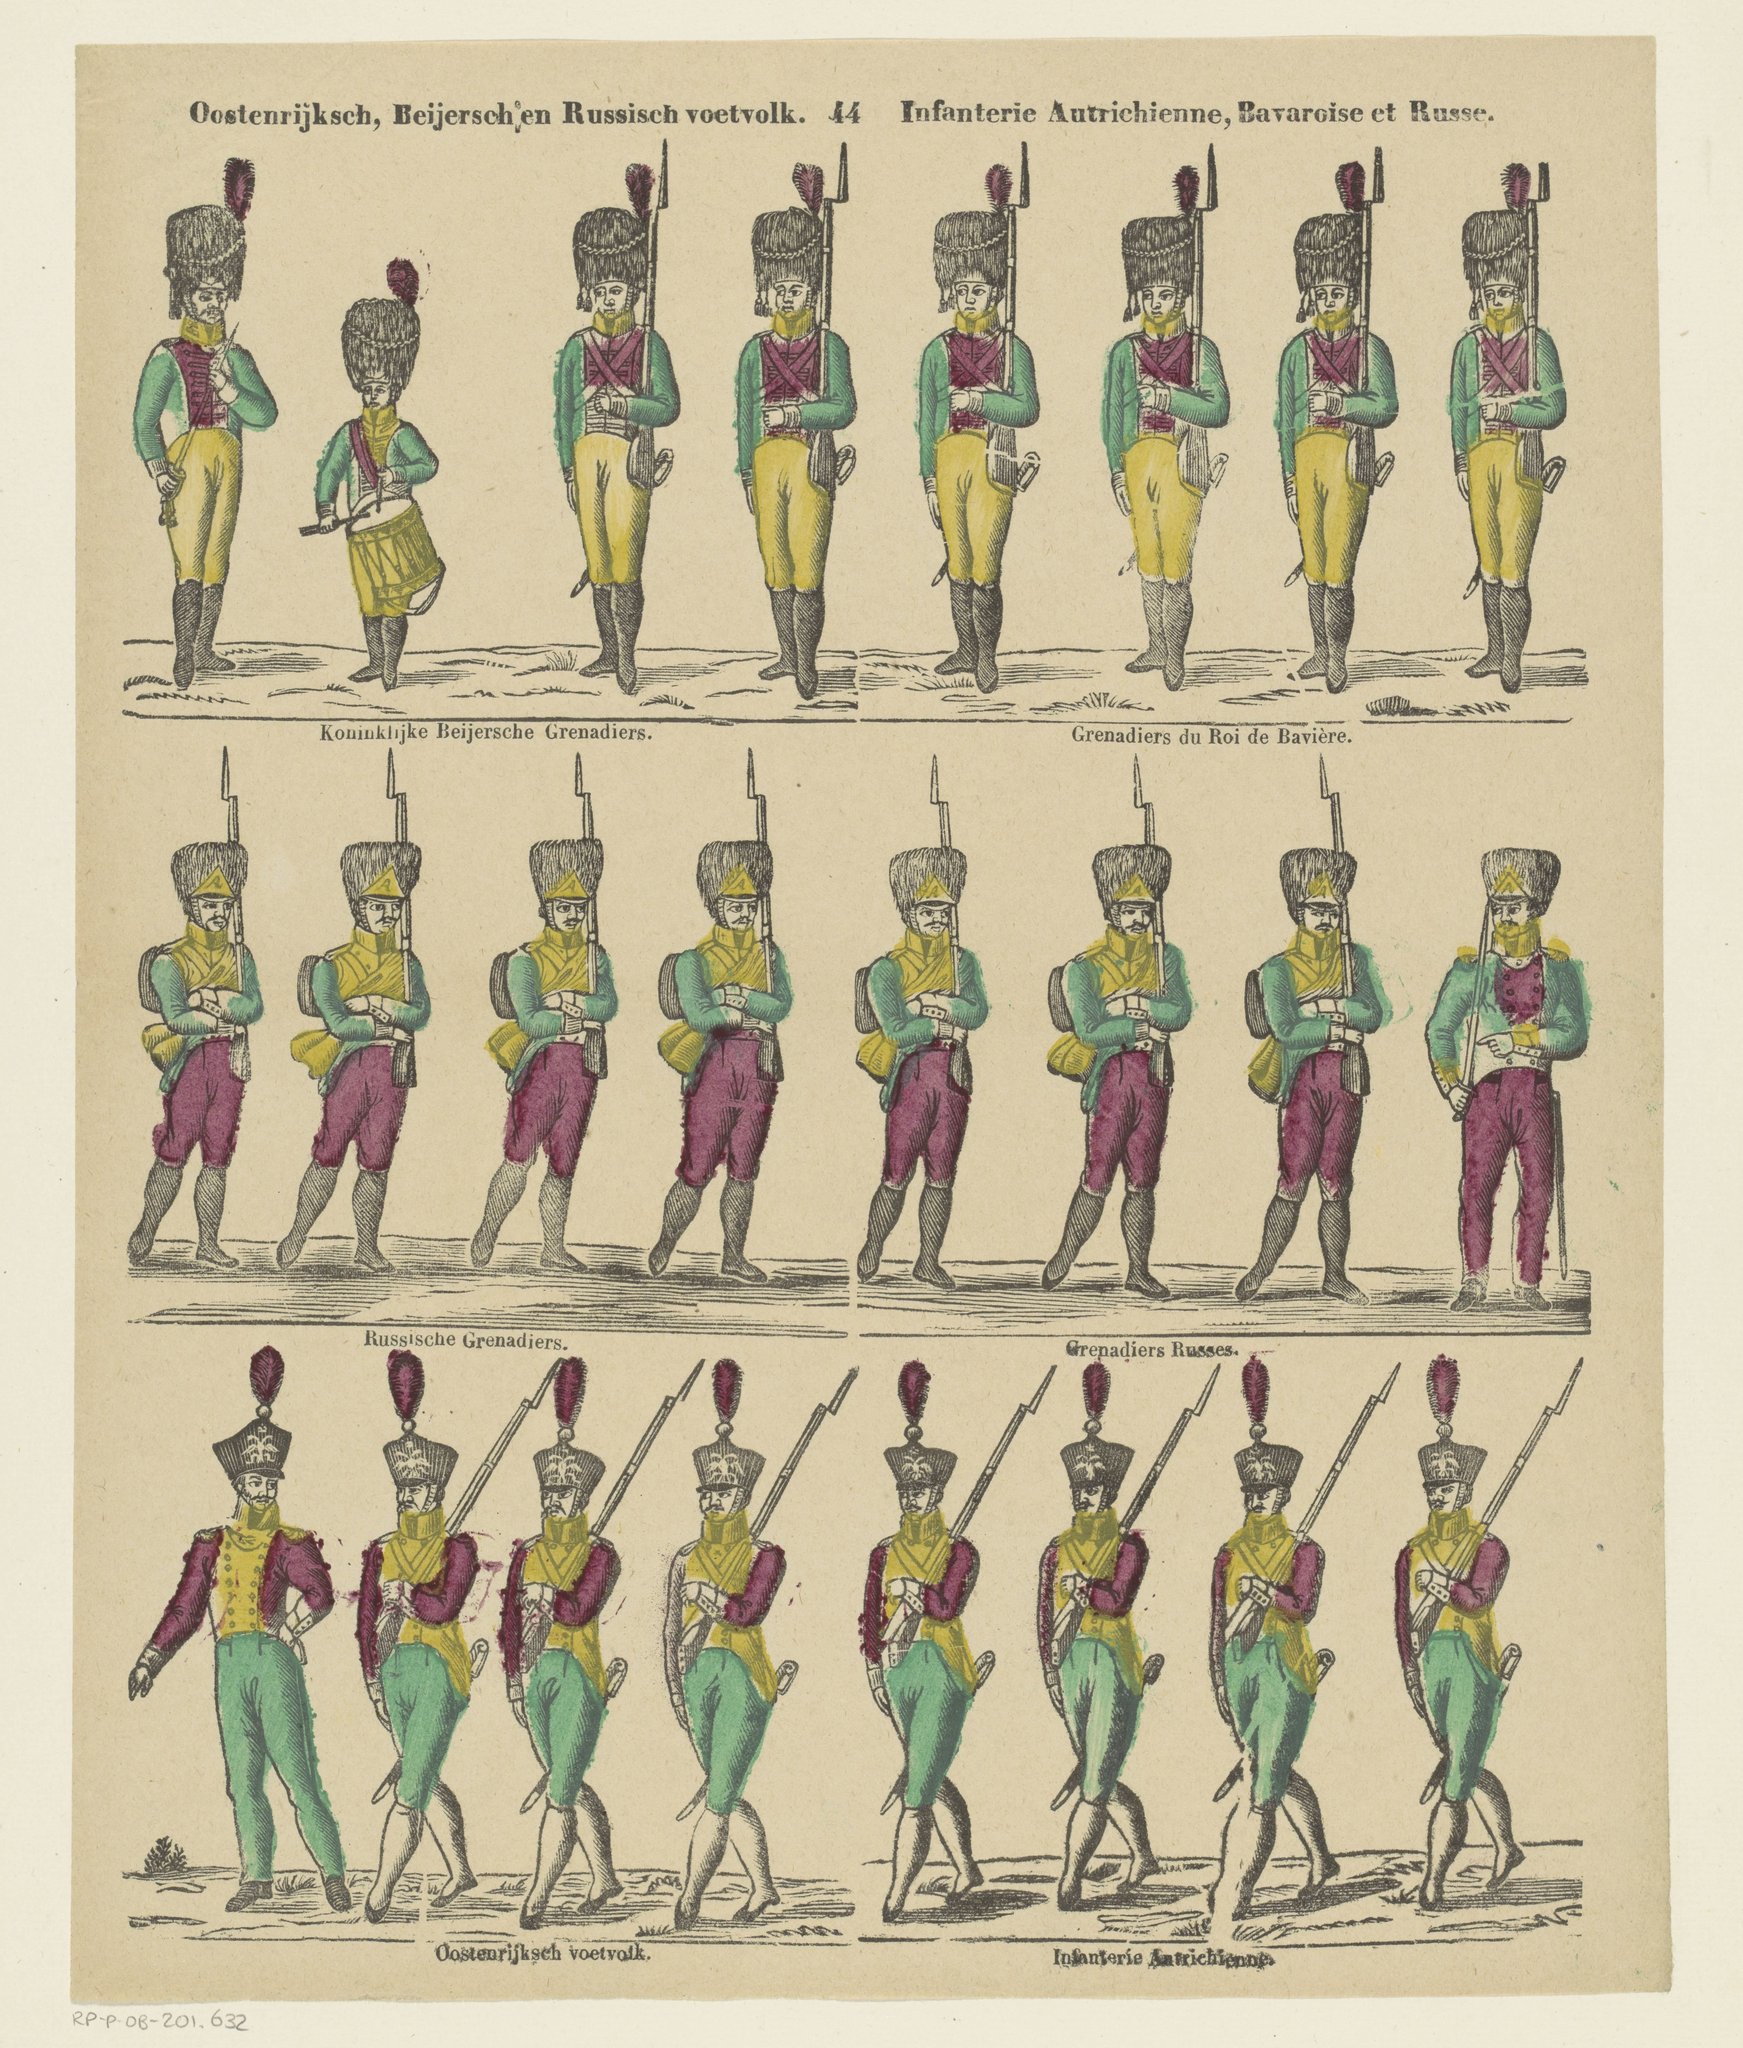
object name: popular print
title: Oostenrijksch, Beijersch, en Russisch voetvolk / Infanterie Autrichienne, Bavaroise et Russe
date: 1800-1833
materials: paper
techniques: colour, letterpress printing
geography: turnhout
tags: the soldier; the soldier's life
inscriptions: collector's mark: Lugt 2760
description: Blad met 3 horizontale rijen met elk acht militairen op een rij. Op de bovenste rij Beierse soldaten, op de middelste rij Russische soldaten en op de onderste rij Oorstenrijkse soldaten. Onder elke voorstelling een onderschrift in het Nederlands en in het Frans. Genummerd midden boven: 44.